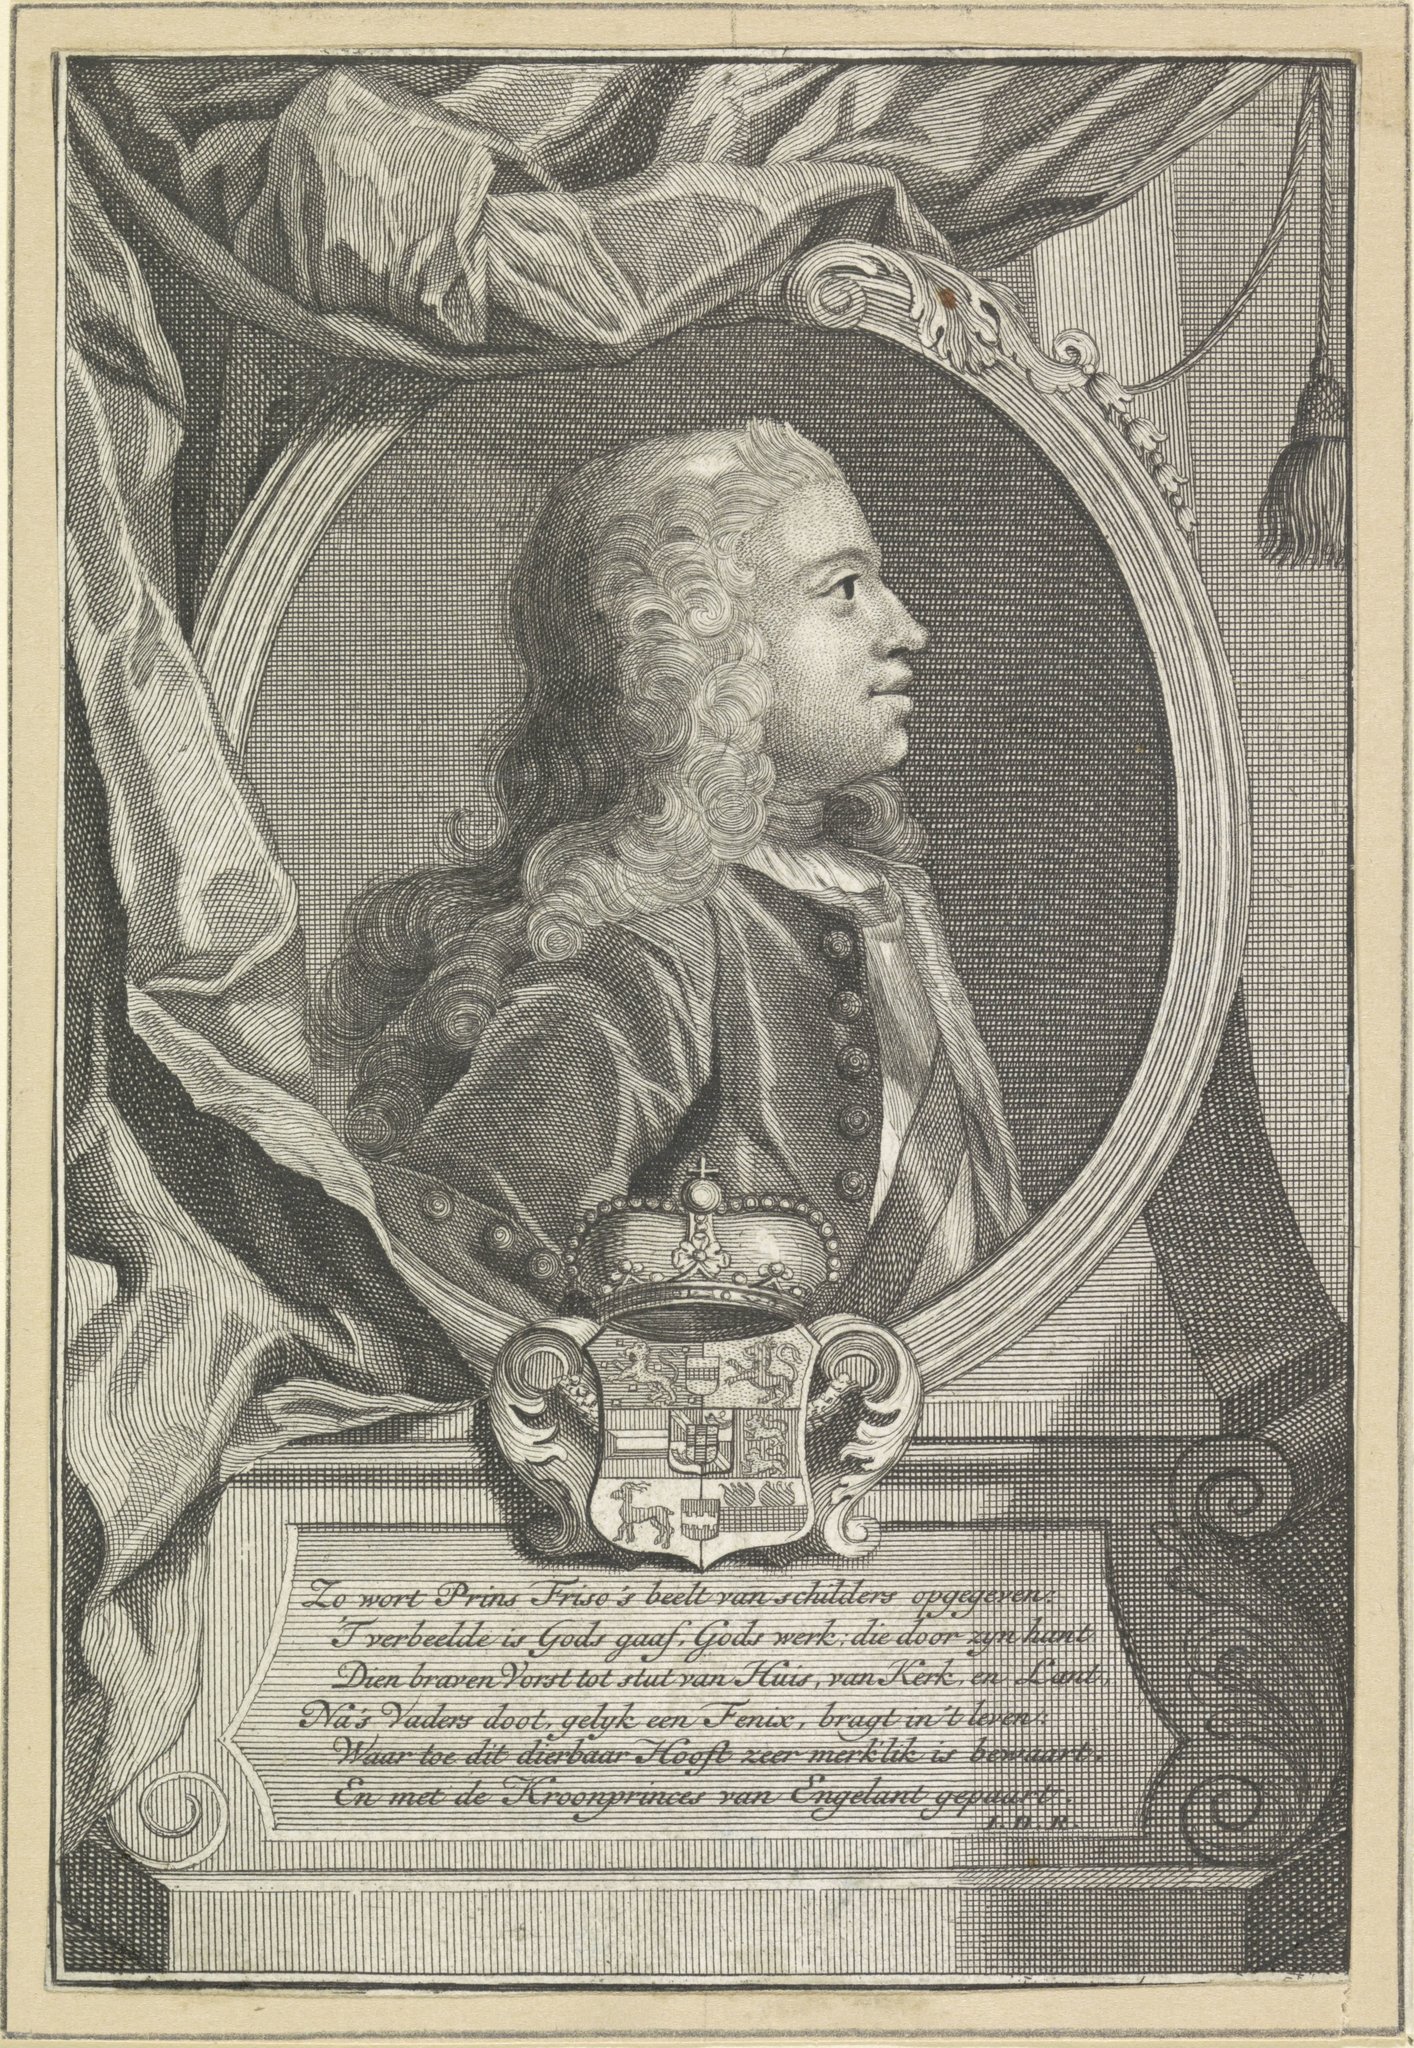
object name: print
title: Portret van Willem IV, prins van Oranje-Nassau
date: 1725-1744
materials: paper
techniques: engraving, etching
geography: amsterdam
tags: willem iv (prins van oranje-nassau)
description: De hier vermelde titel verwijst naar de hoogst verkregen titel van de geportretteerde, niet per se naar de titel die de geportretteerde op deze voorstelling draagt.